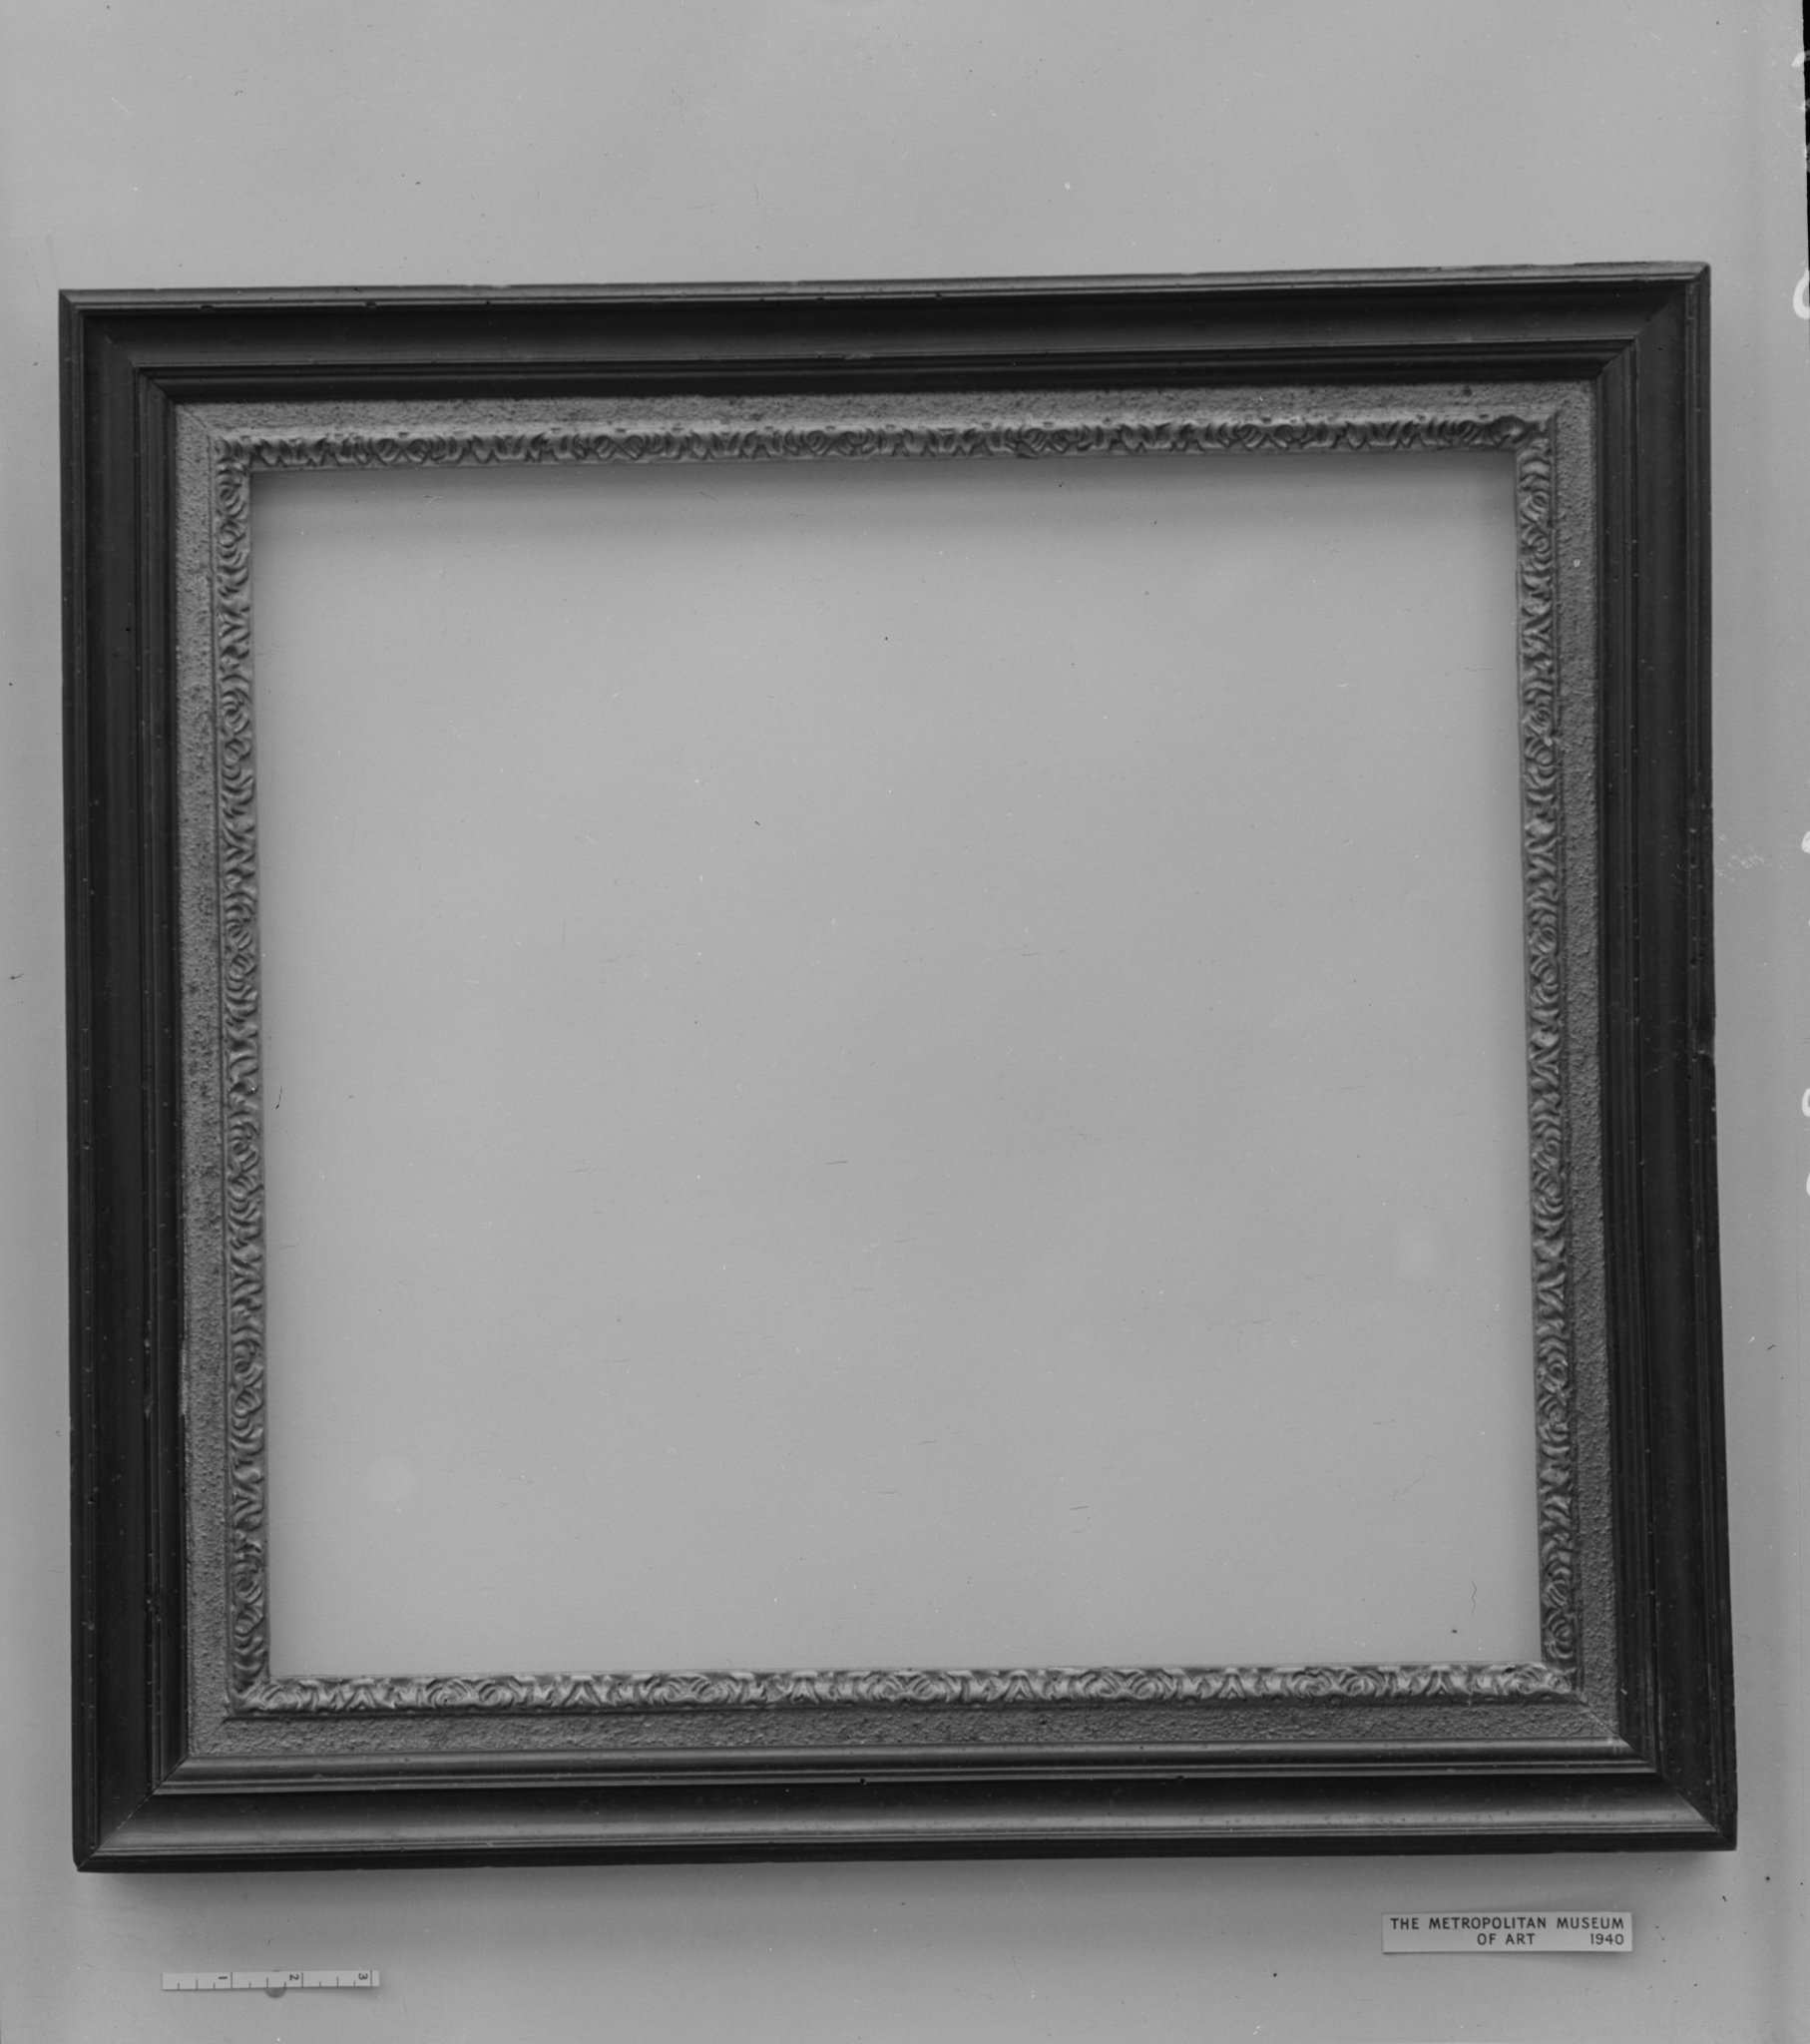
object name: frame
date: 1700-1800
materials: wood